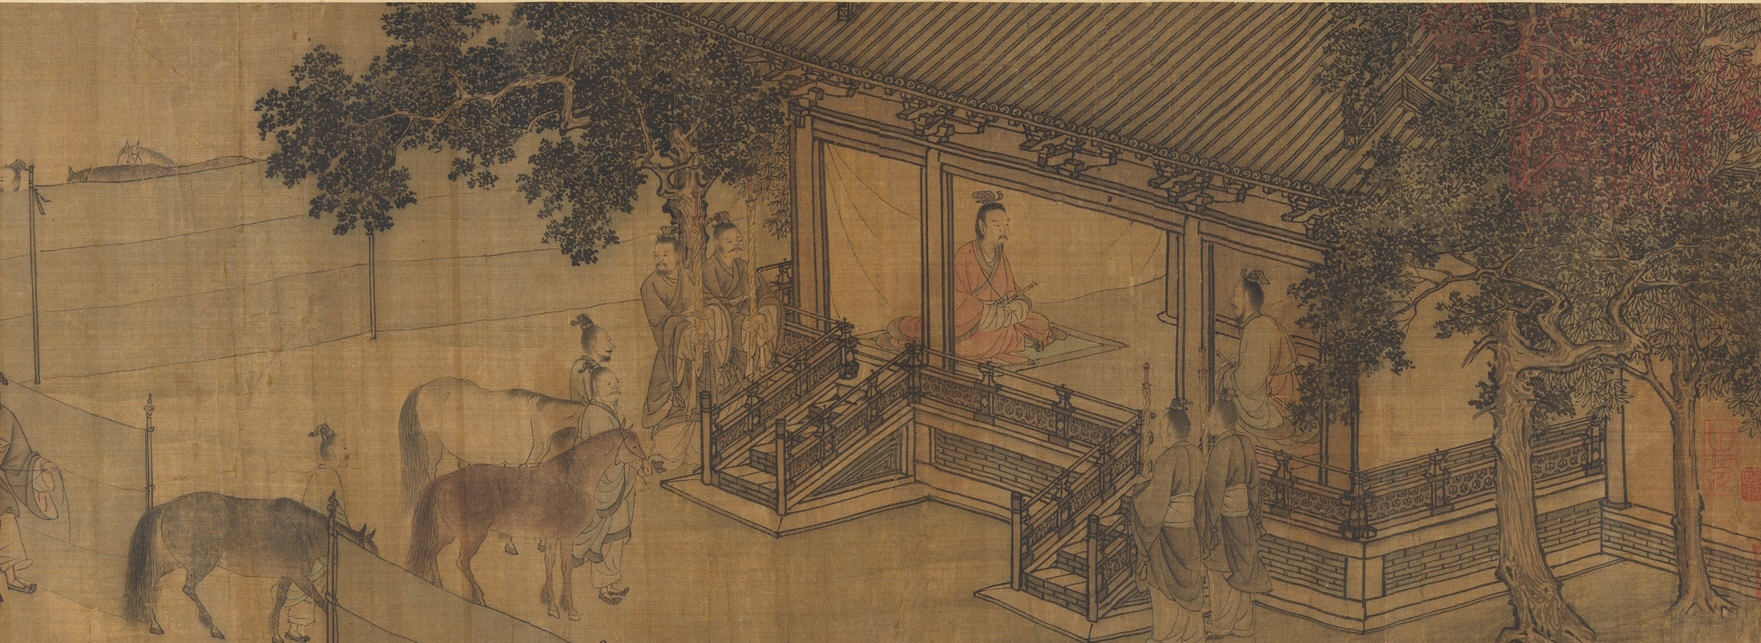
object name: handscroll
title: Duke Wen of Jin Recovering His State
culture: chinese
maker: li tang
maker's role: artist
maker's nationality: chinese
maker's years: 1070-1159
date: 1134-1166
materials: ink, silk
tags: buildings,men,horses